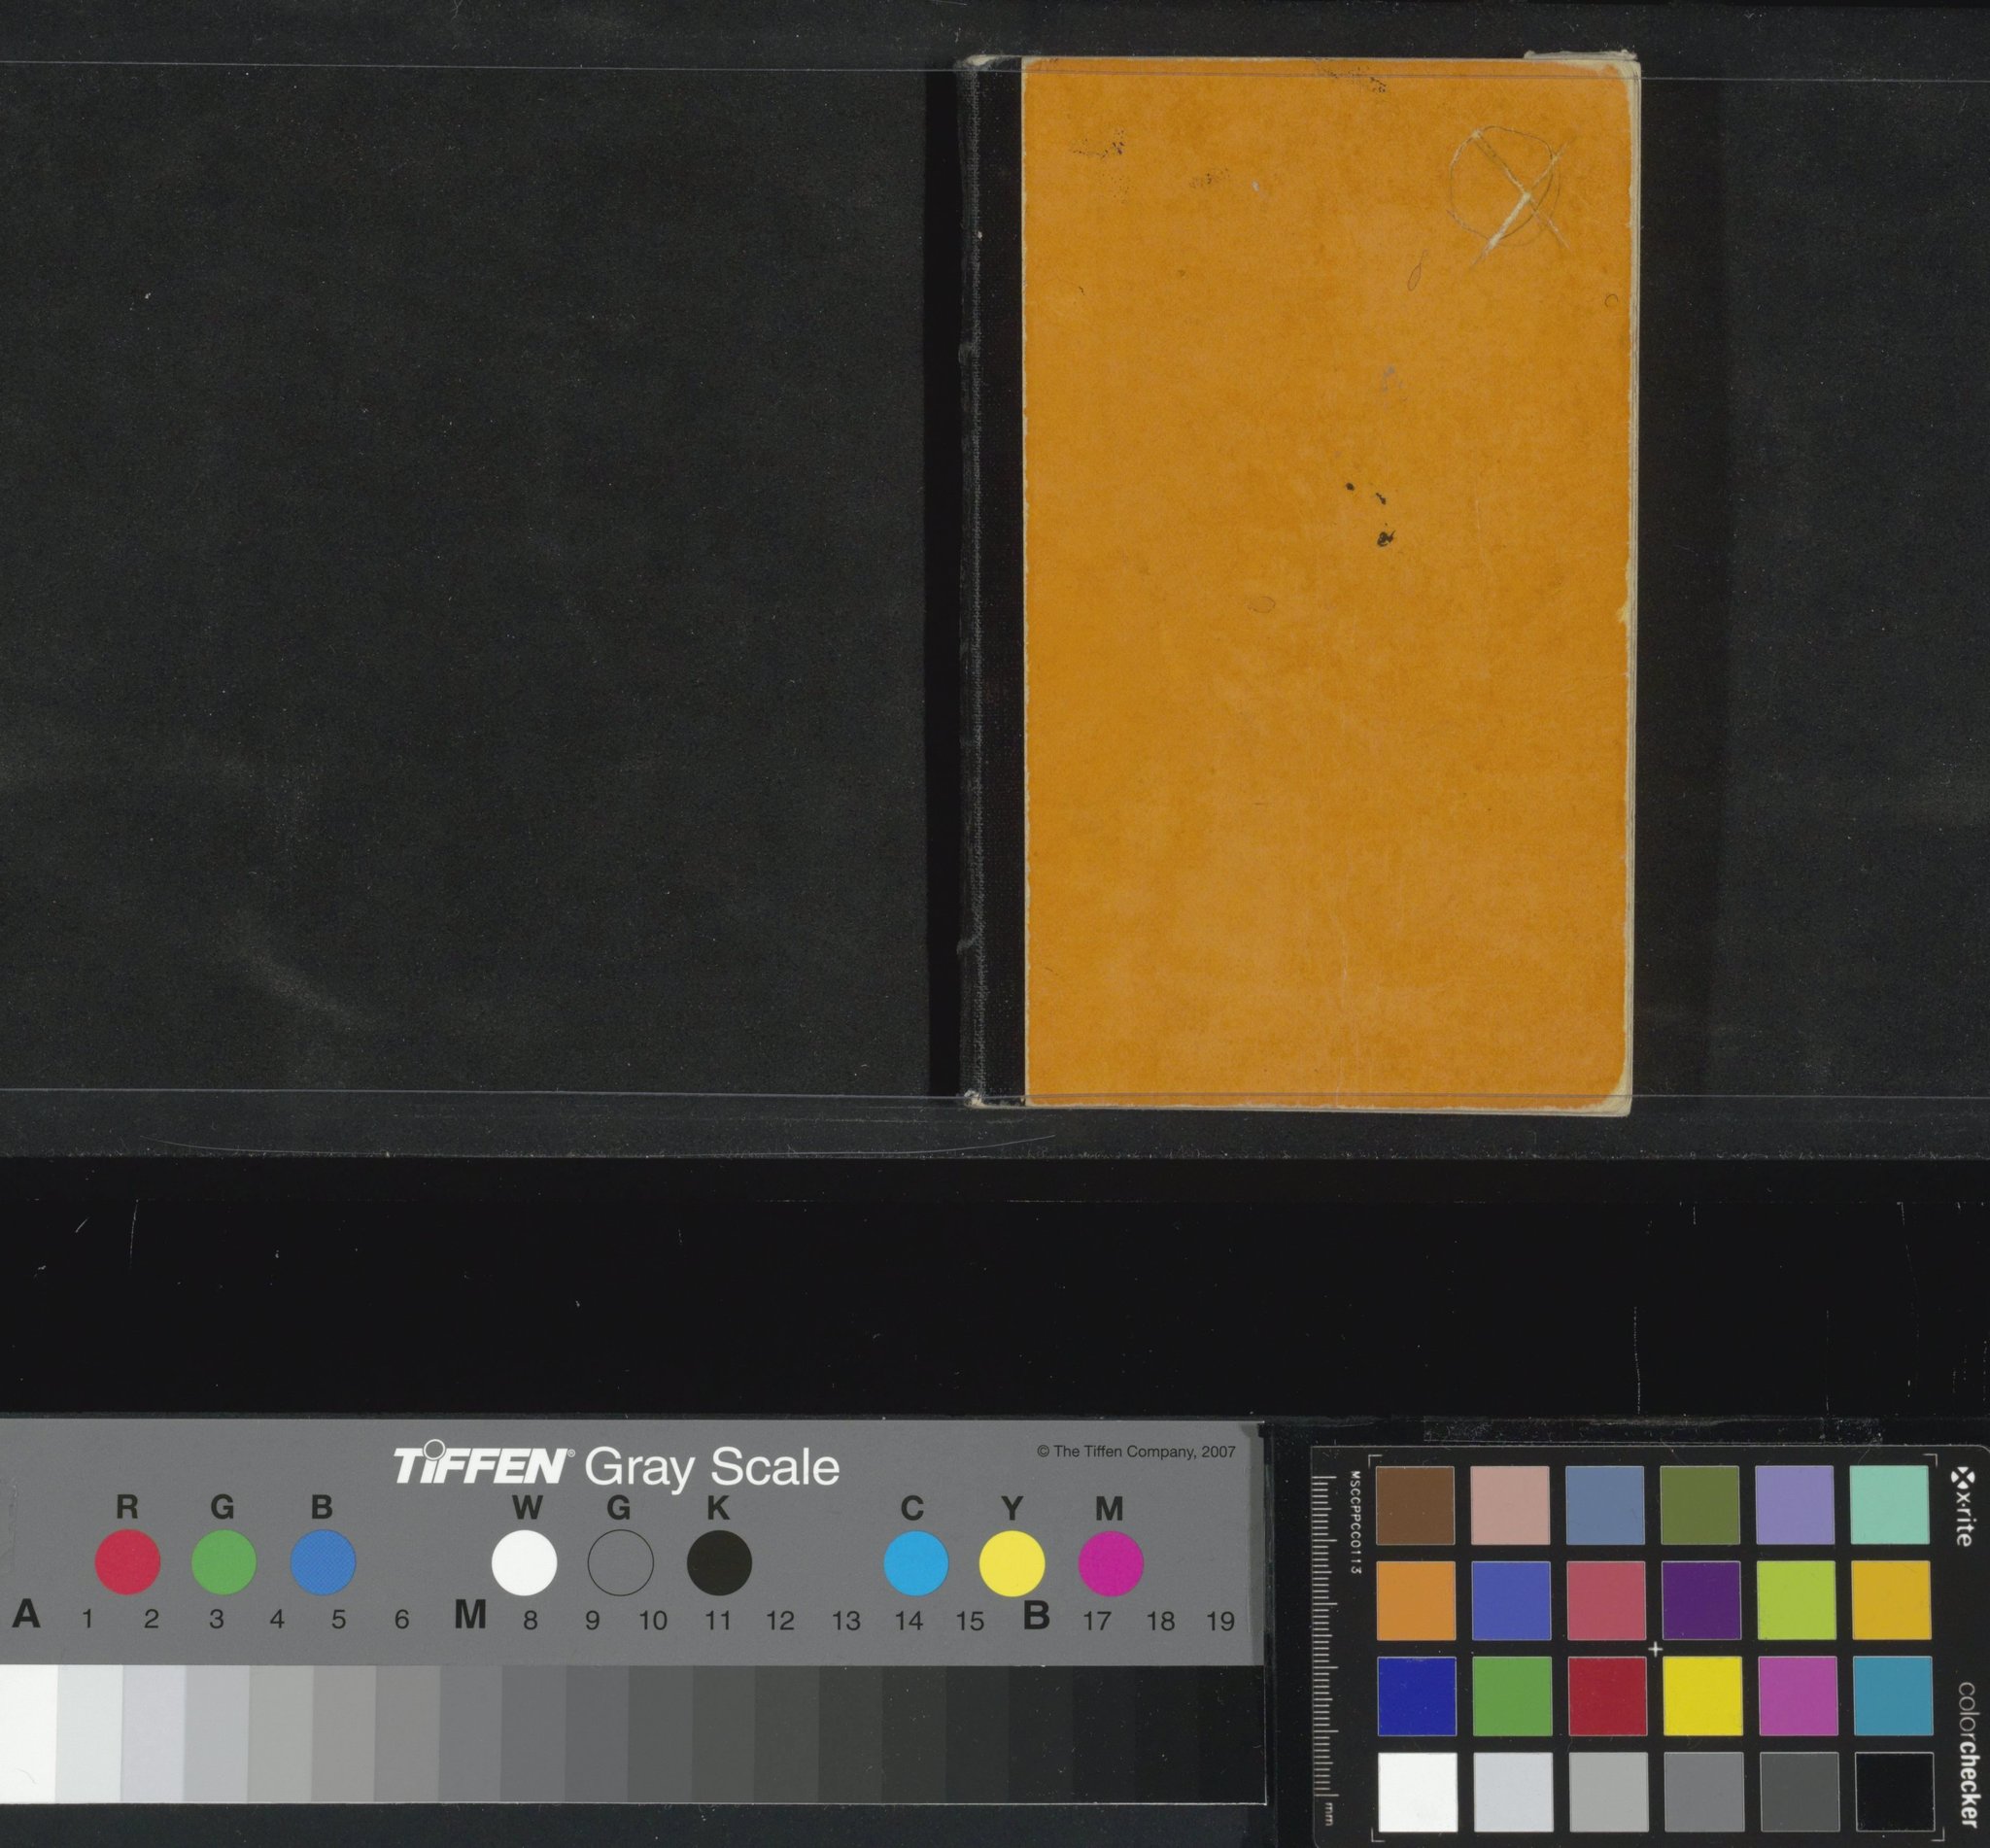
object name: sketchbook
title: Schetsboek met 74 bladen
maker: marius bauer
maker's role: draughtsman, print maker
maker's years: 1867-1932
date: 1931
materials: cardboard, chalk, linen, paper, pencil, watercolor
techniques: brush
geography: java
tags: asiatic races and peoples, ritual practices ~ hinduism, buddhism, jainism, folk costume, regional costume, landscapes (+ landscape with figures, staffage), street (+ city(-scape) with figures, staffage), java, indonesia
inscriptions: retailer's mark: ‘G.G.T. van Dorp&Co/ Semarang/ Sourabaya/ Bandoeng’, collector's mark: Lugt 2228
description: Schetsboek bestaande uit 74 bladen met voornamelijk figuurstudies van Indonesiërs in traditioneel kostuum, dansers, een gamelanorkest, optochten en een rouwstoet voor een crematie. Tevens enkele straatgezichten en landschappen te Java, Bali en Sumatra.